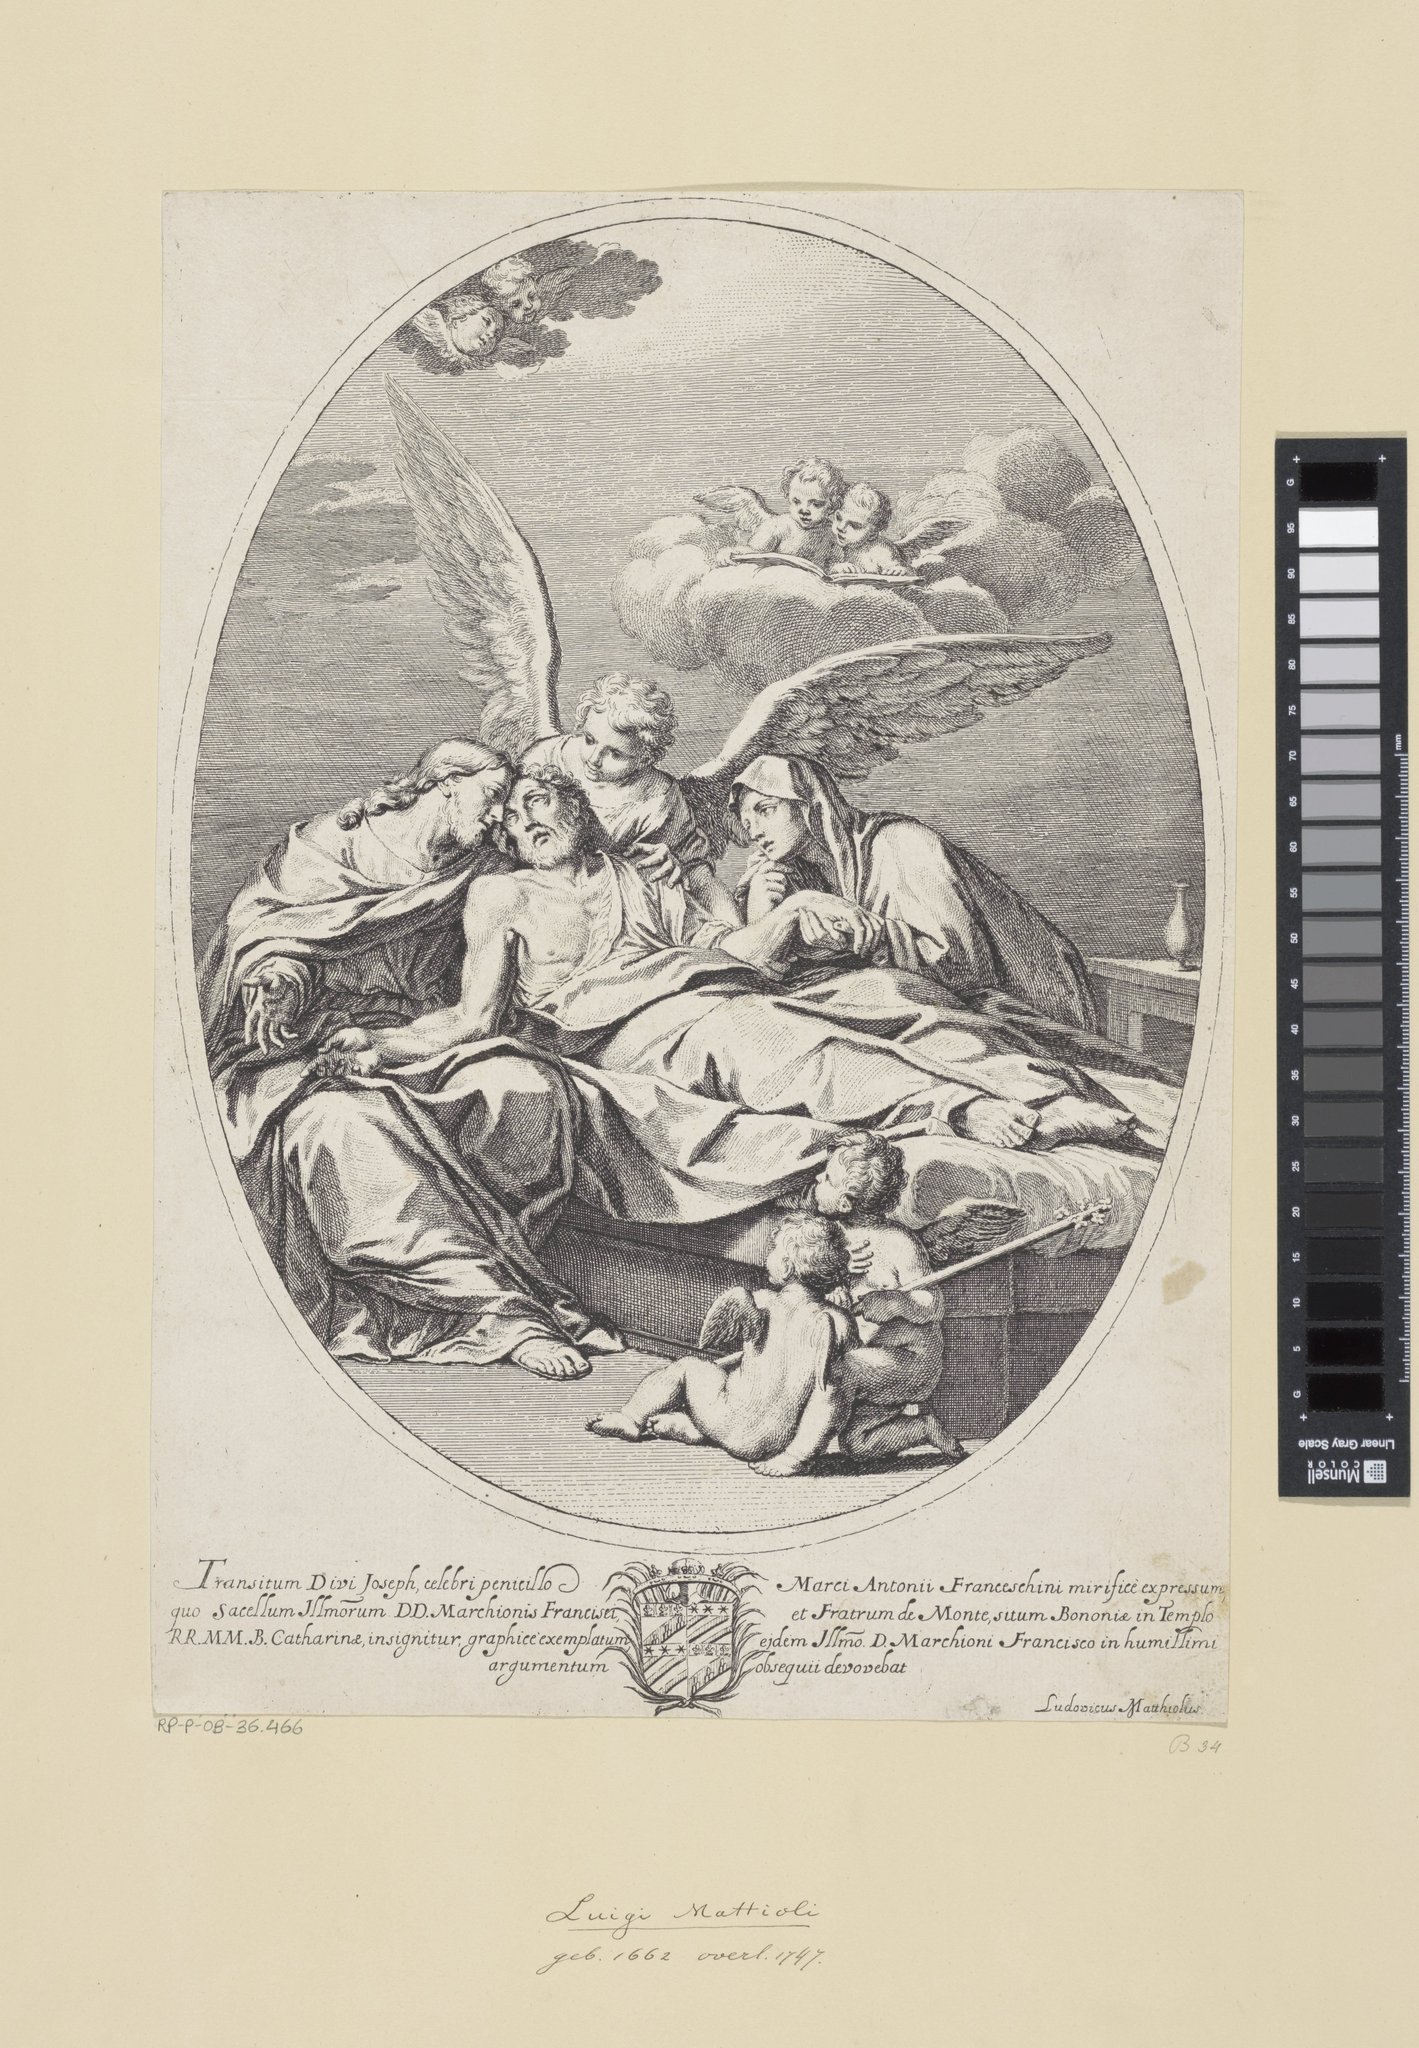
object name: print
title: Sterfbed van Jozef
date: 1672-1747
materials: paper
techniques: etching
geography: italy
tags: joseph on his deathbed; christ and mary present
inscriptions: collector's mark: Lugt 240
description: Jozef ligt op zijn sterfbed. Naast hem zitten Christus en Maria. Achter Jozef een engel. Tekst in het Latijn en wapenschild onder voorstelling.